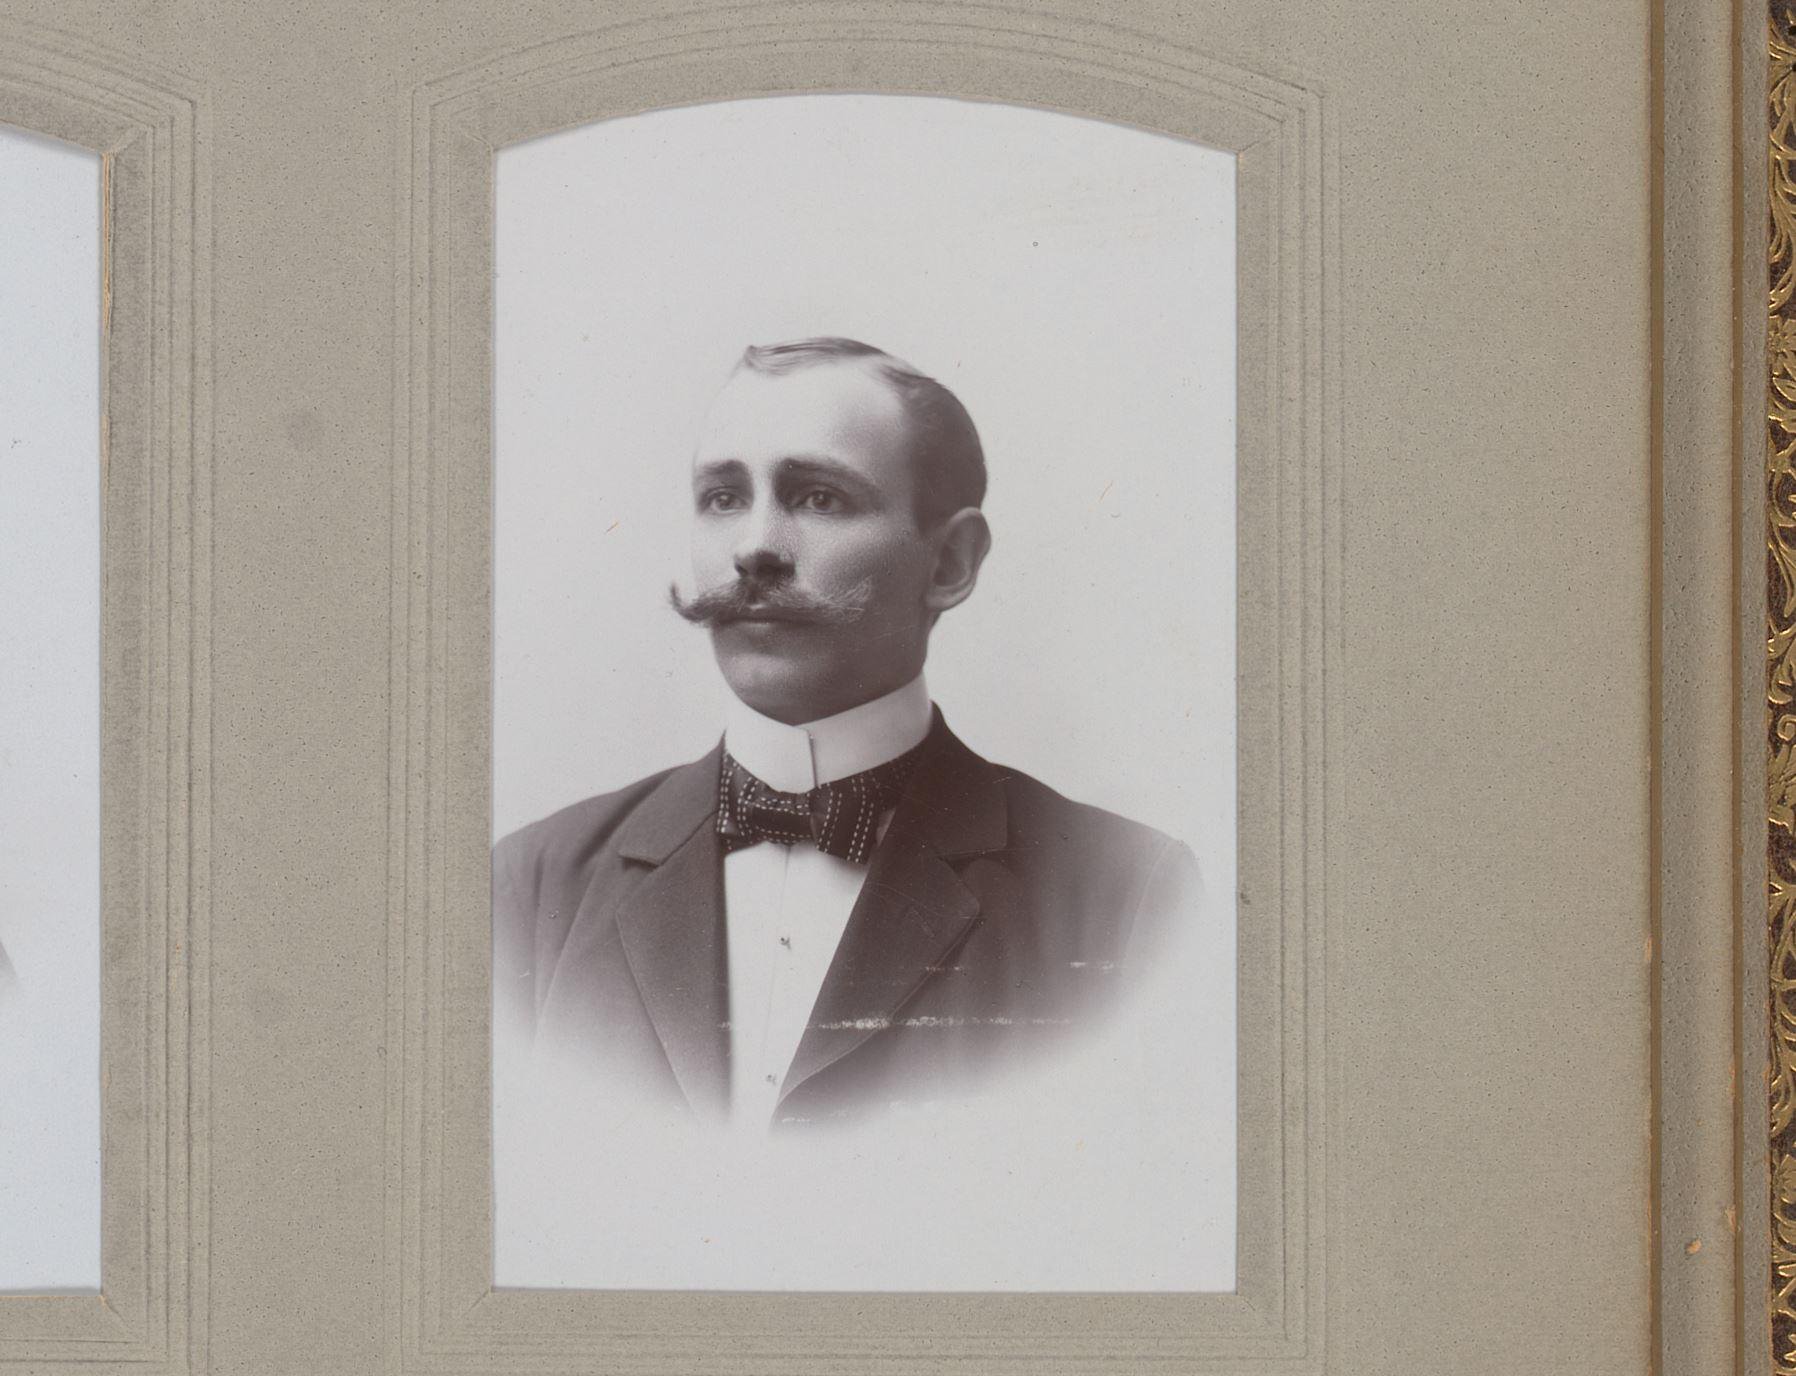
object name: carte de visite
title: Portret van een man met snor en vlinderstrik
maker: amanda johansson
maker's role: fotograaf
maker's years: 1859-1933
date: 1880-1920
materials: cardboard, photographic support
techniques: collodion silver print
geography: stockholm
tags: moustache, historical persons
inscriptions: inscription: ‘Amanda Johansson/ Hornsgatan 54/ Sibyllegatan 32’